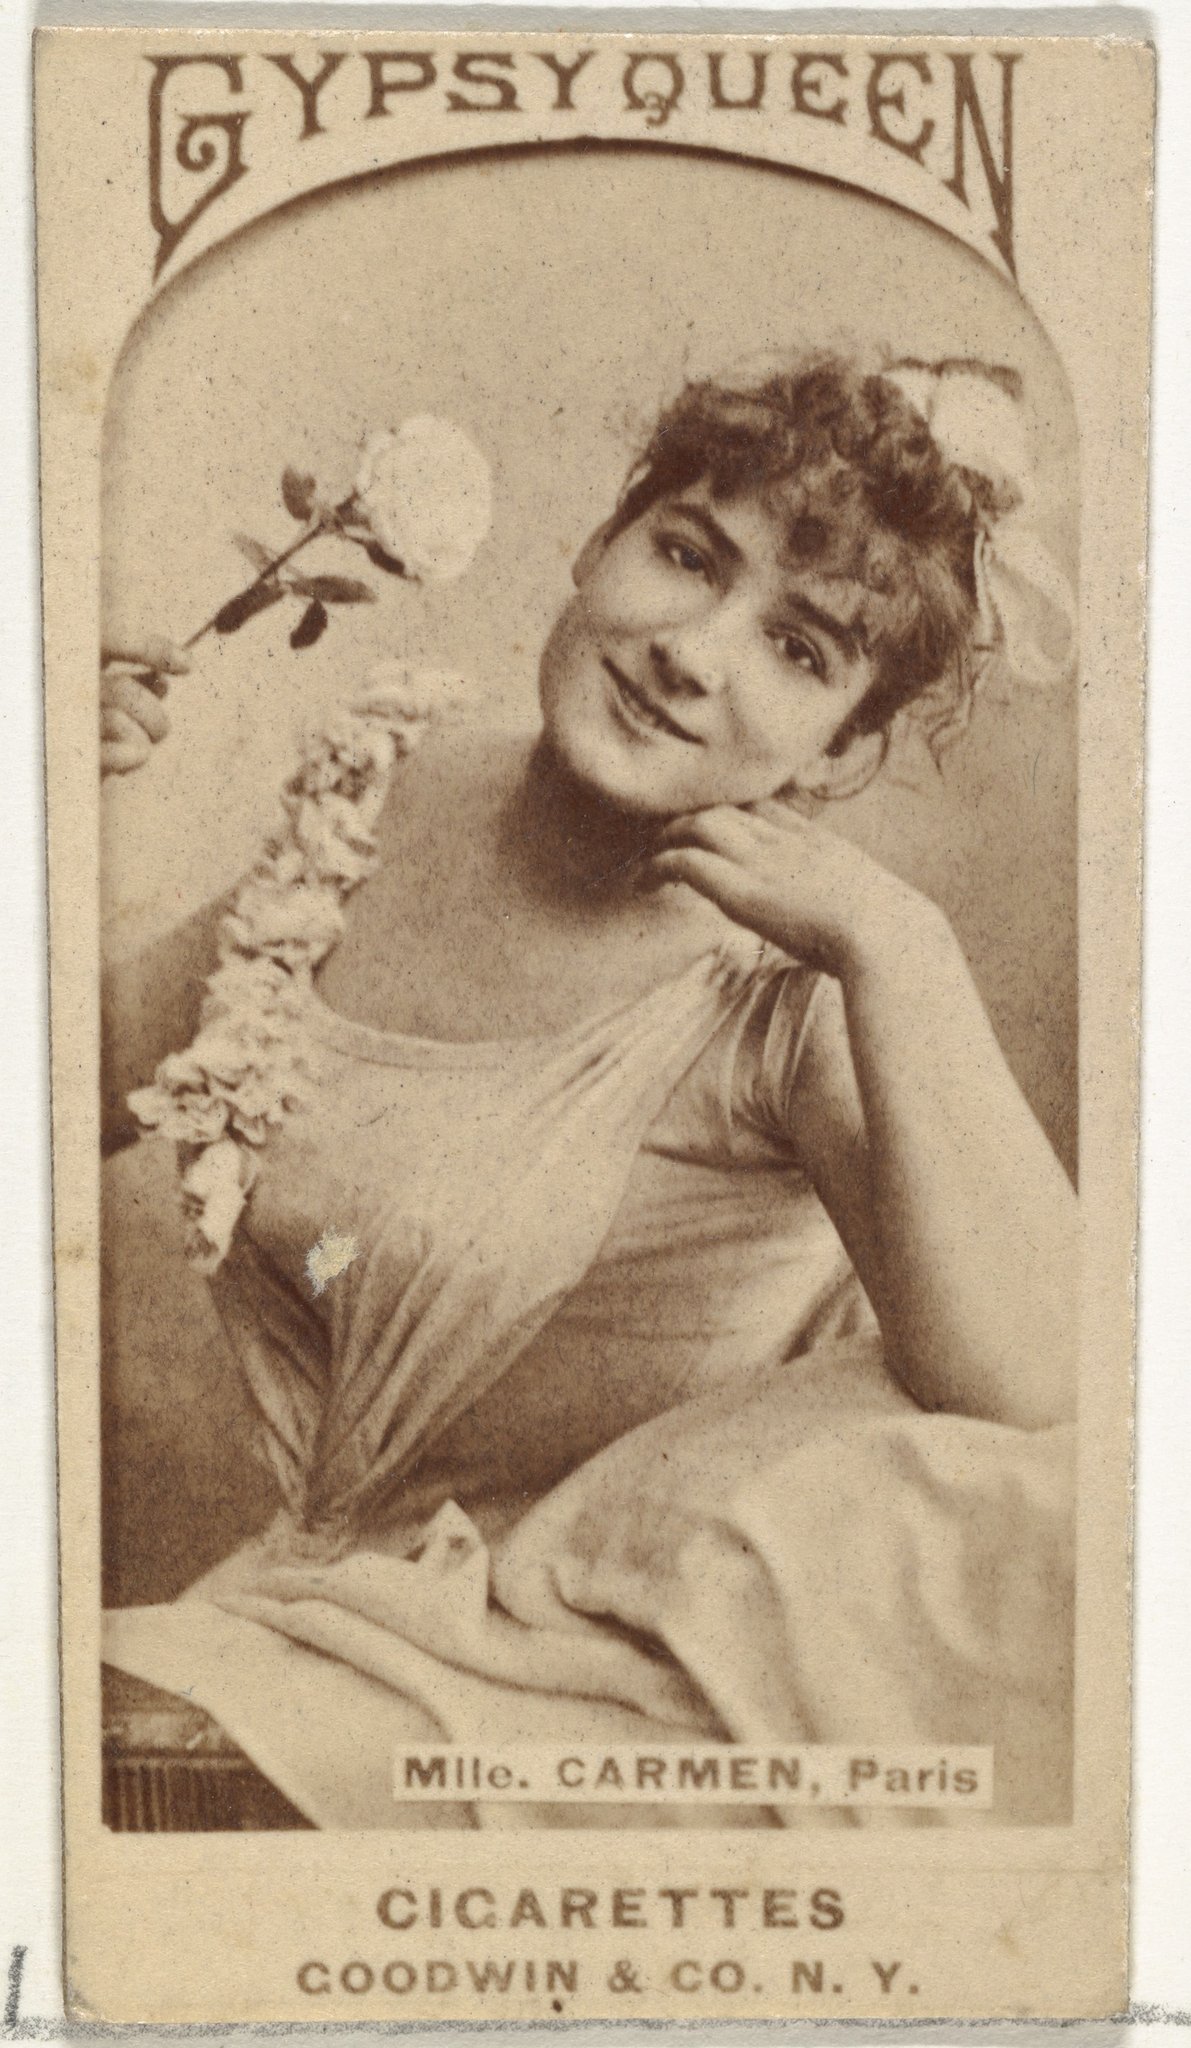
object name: photograph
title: Mlle. Carmen, Paris, from the Actors and Actresses series (N171) for Gypsy Queen Cigarettes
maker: goodwin & company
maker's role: publisher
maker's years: 1850-1950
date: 1886-1890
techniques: albumen silver print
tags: portraits,women,actresses